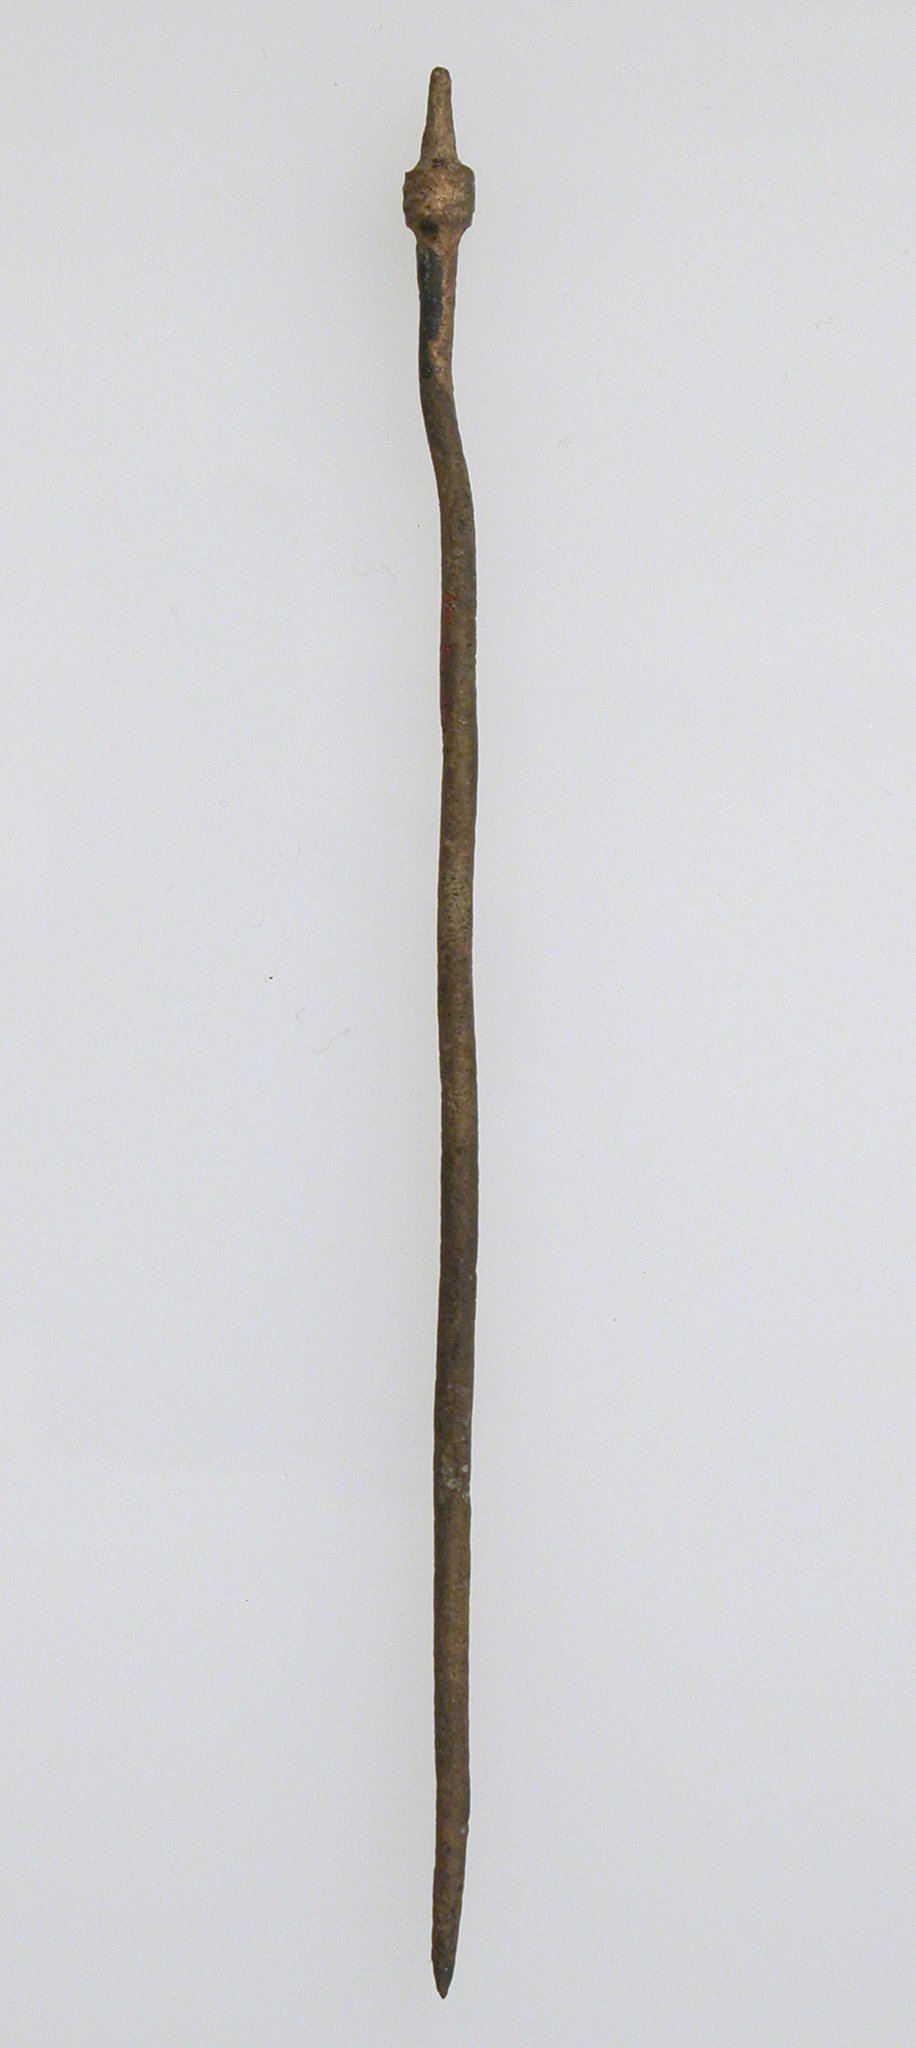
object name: hairpin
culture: roman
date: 1-400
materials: copper alloy